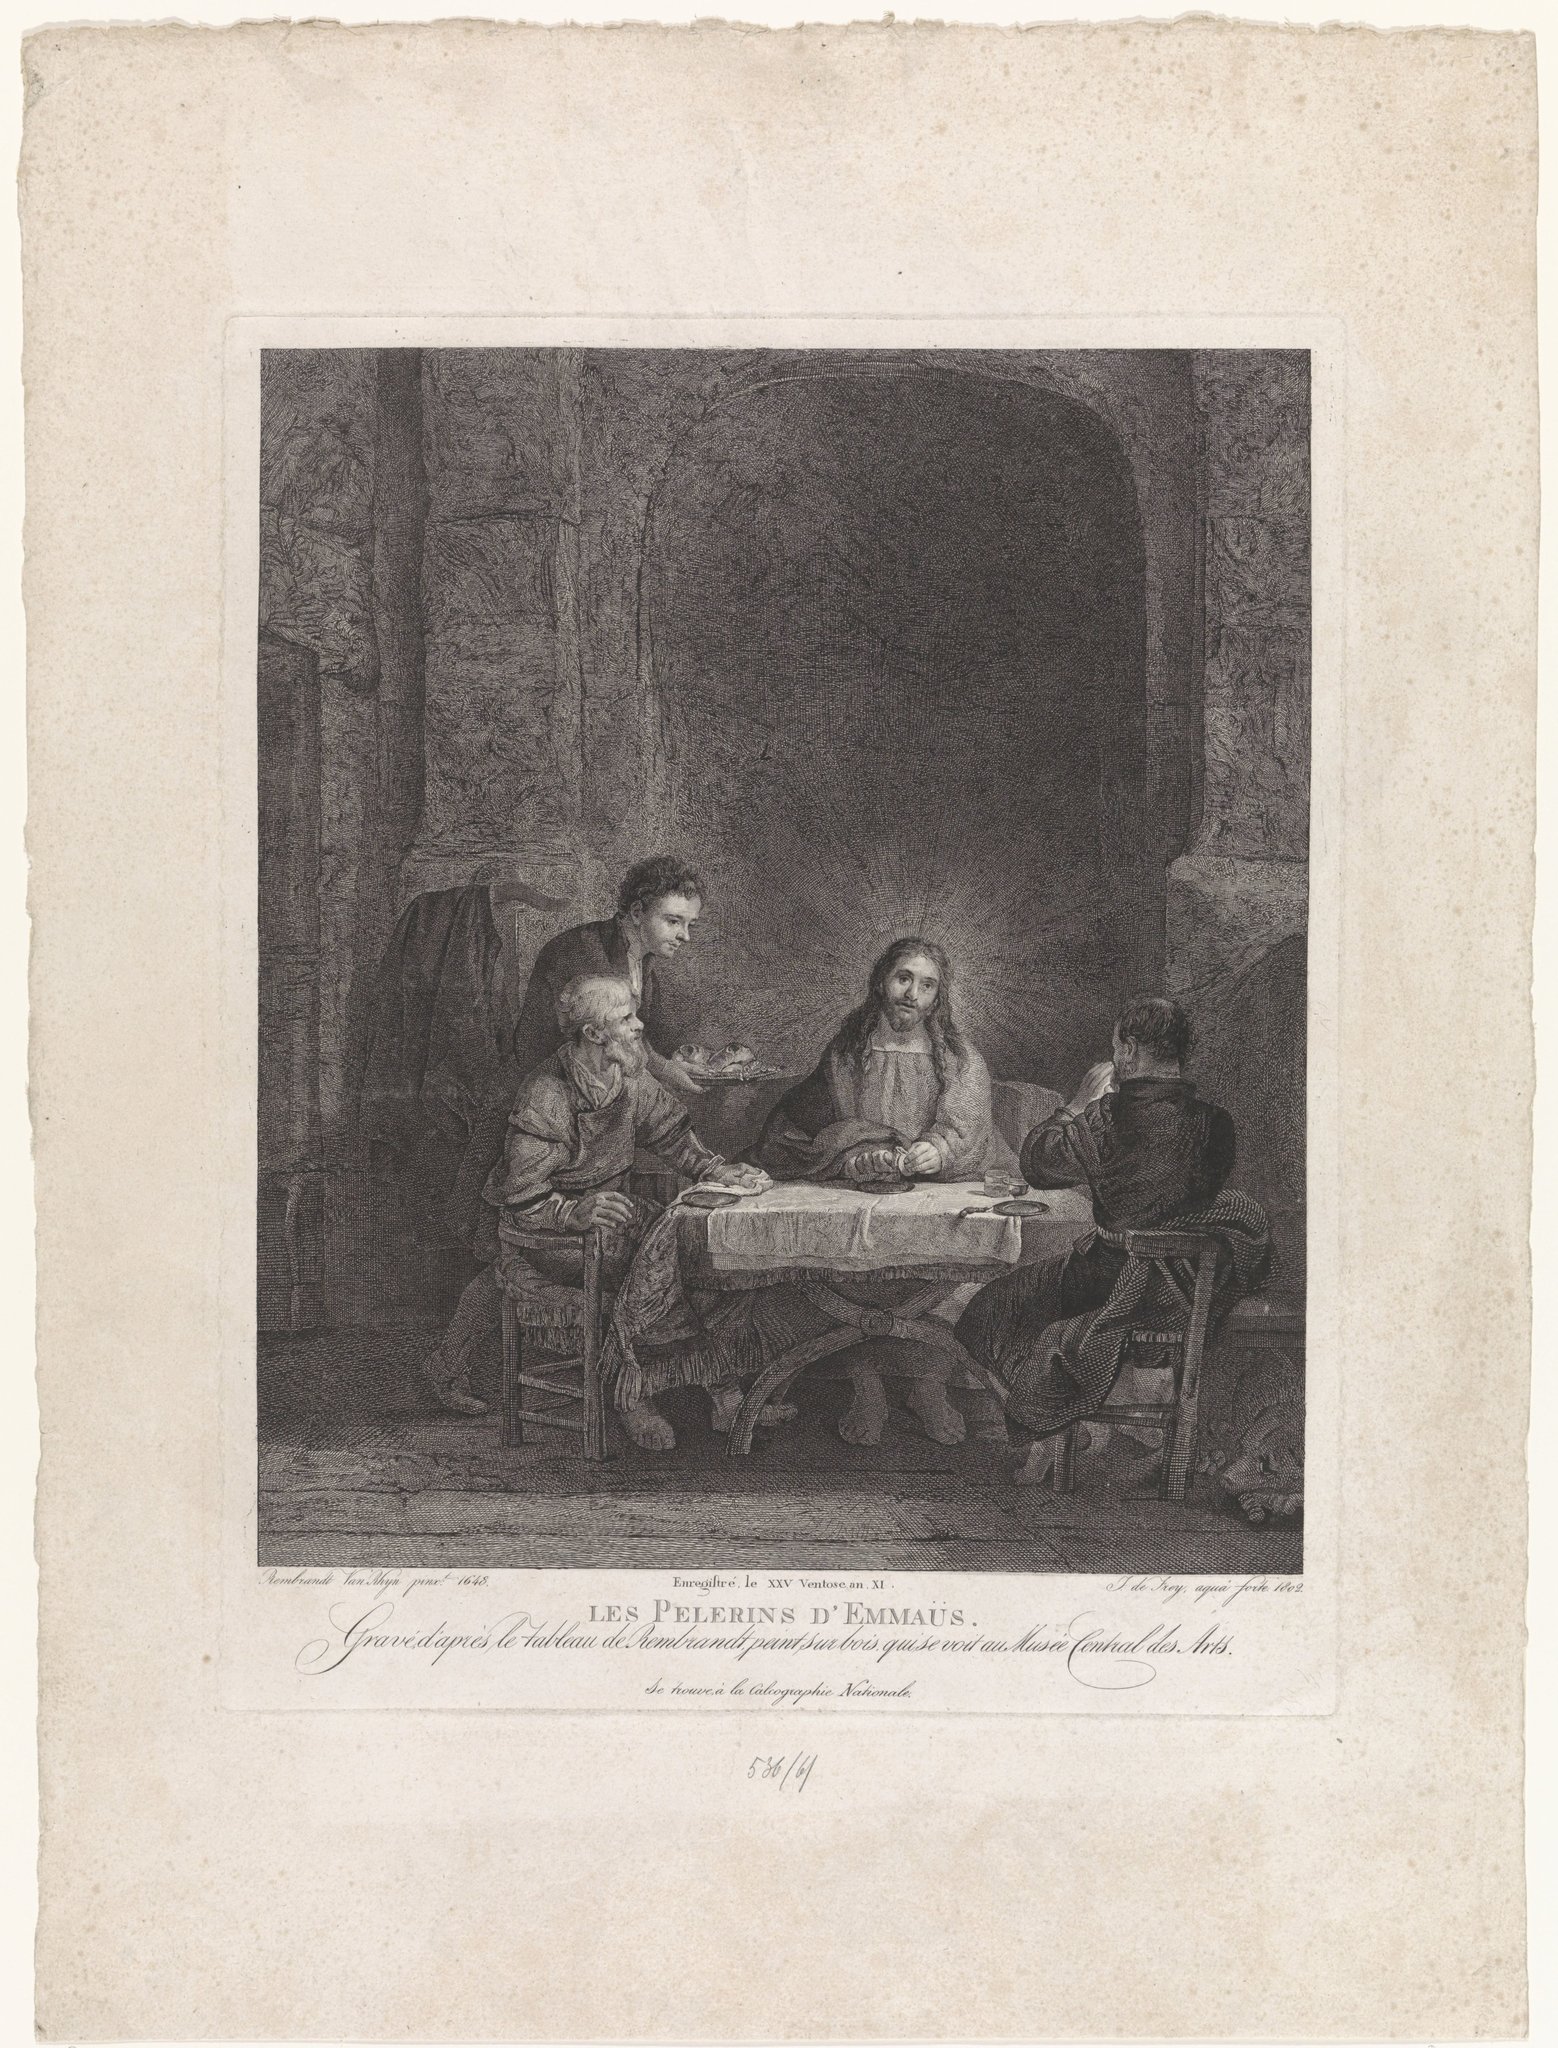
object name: print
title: Maaltijd te Emmaüs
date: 1802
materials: paper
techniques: engraving, etching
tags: the supper at emmaus: christ is recognized while blessing or breaking the bread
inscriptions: date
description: Christus zit met de twee discipelen aan tafel. Hij breekt het brood en spreekt de zegen uit en op dat moment herkennen de twee mannen hem. Linkss brengt de bediende een bord met eten.